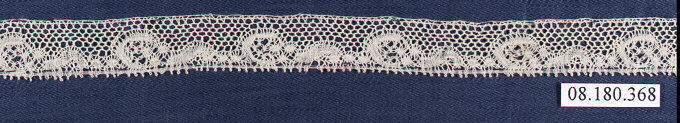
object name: piece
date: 1701-1800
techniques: lace